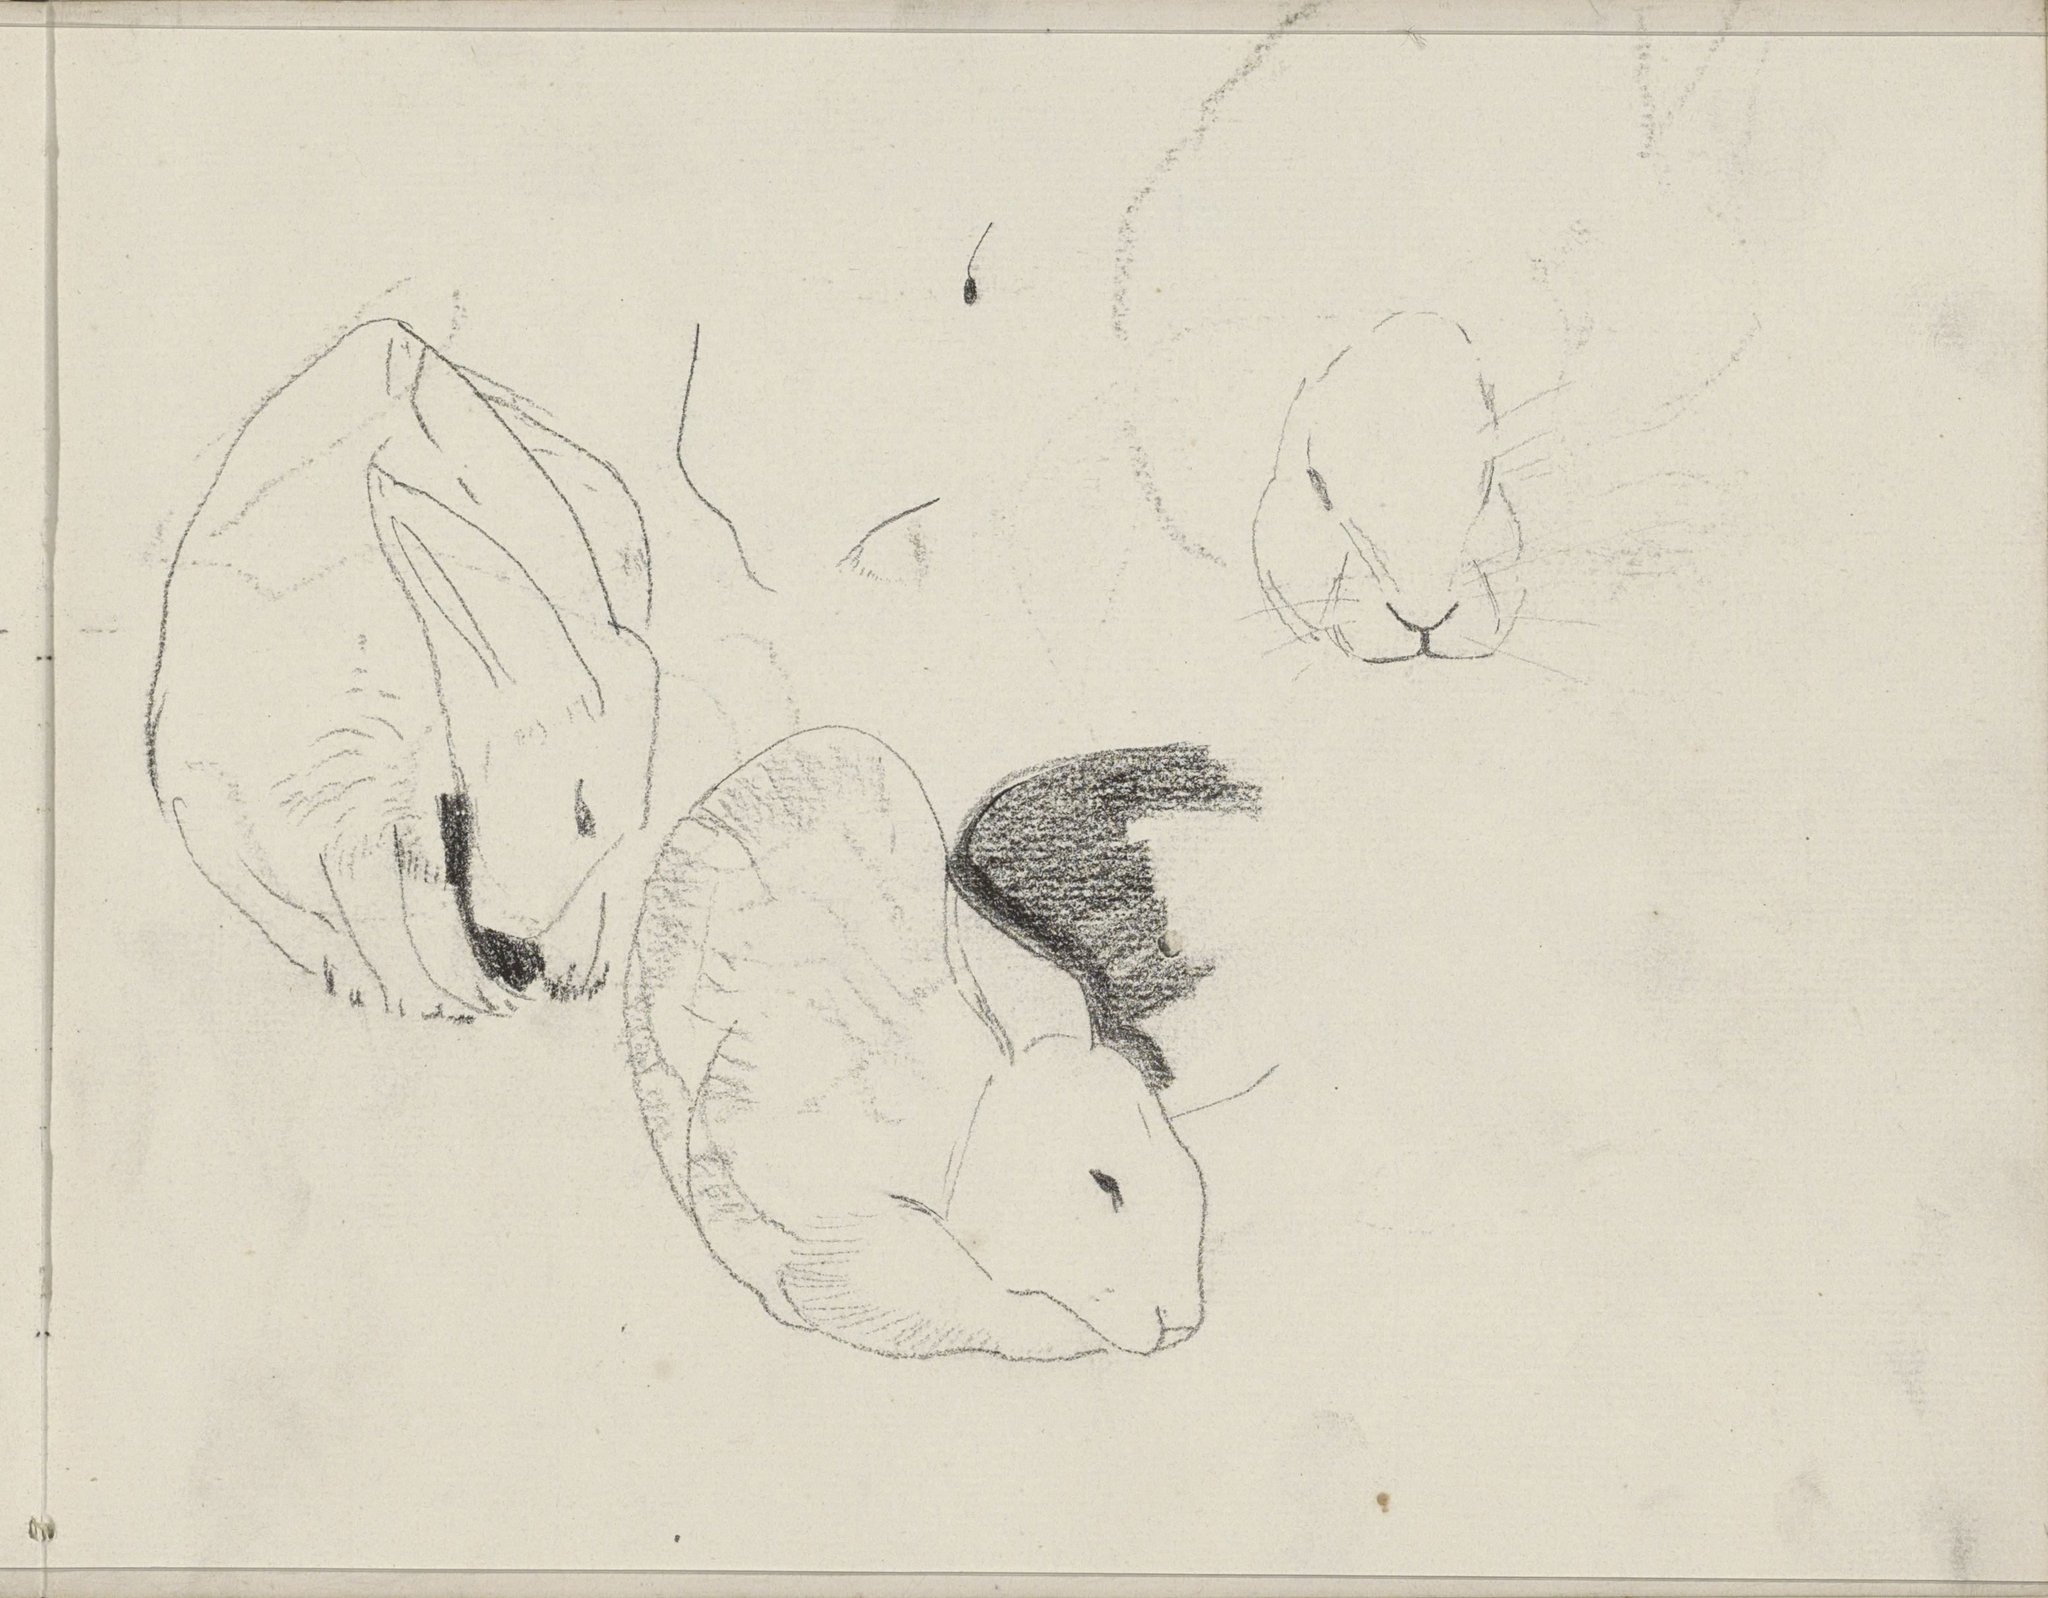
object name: sketchbook leaf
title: Konijnen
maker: carel adolph lion cachet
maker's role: draughtsman, print maker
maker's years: 1864-1945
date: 1896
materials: chalk, paper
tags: rodents: rabbit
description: Blad 20 recto uit een schetsboek met 44 bladen.